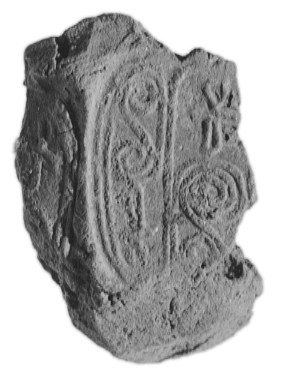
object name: sealing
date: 2030-1640 BCE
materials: clay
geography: egypt